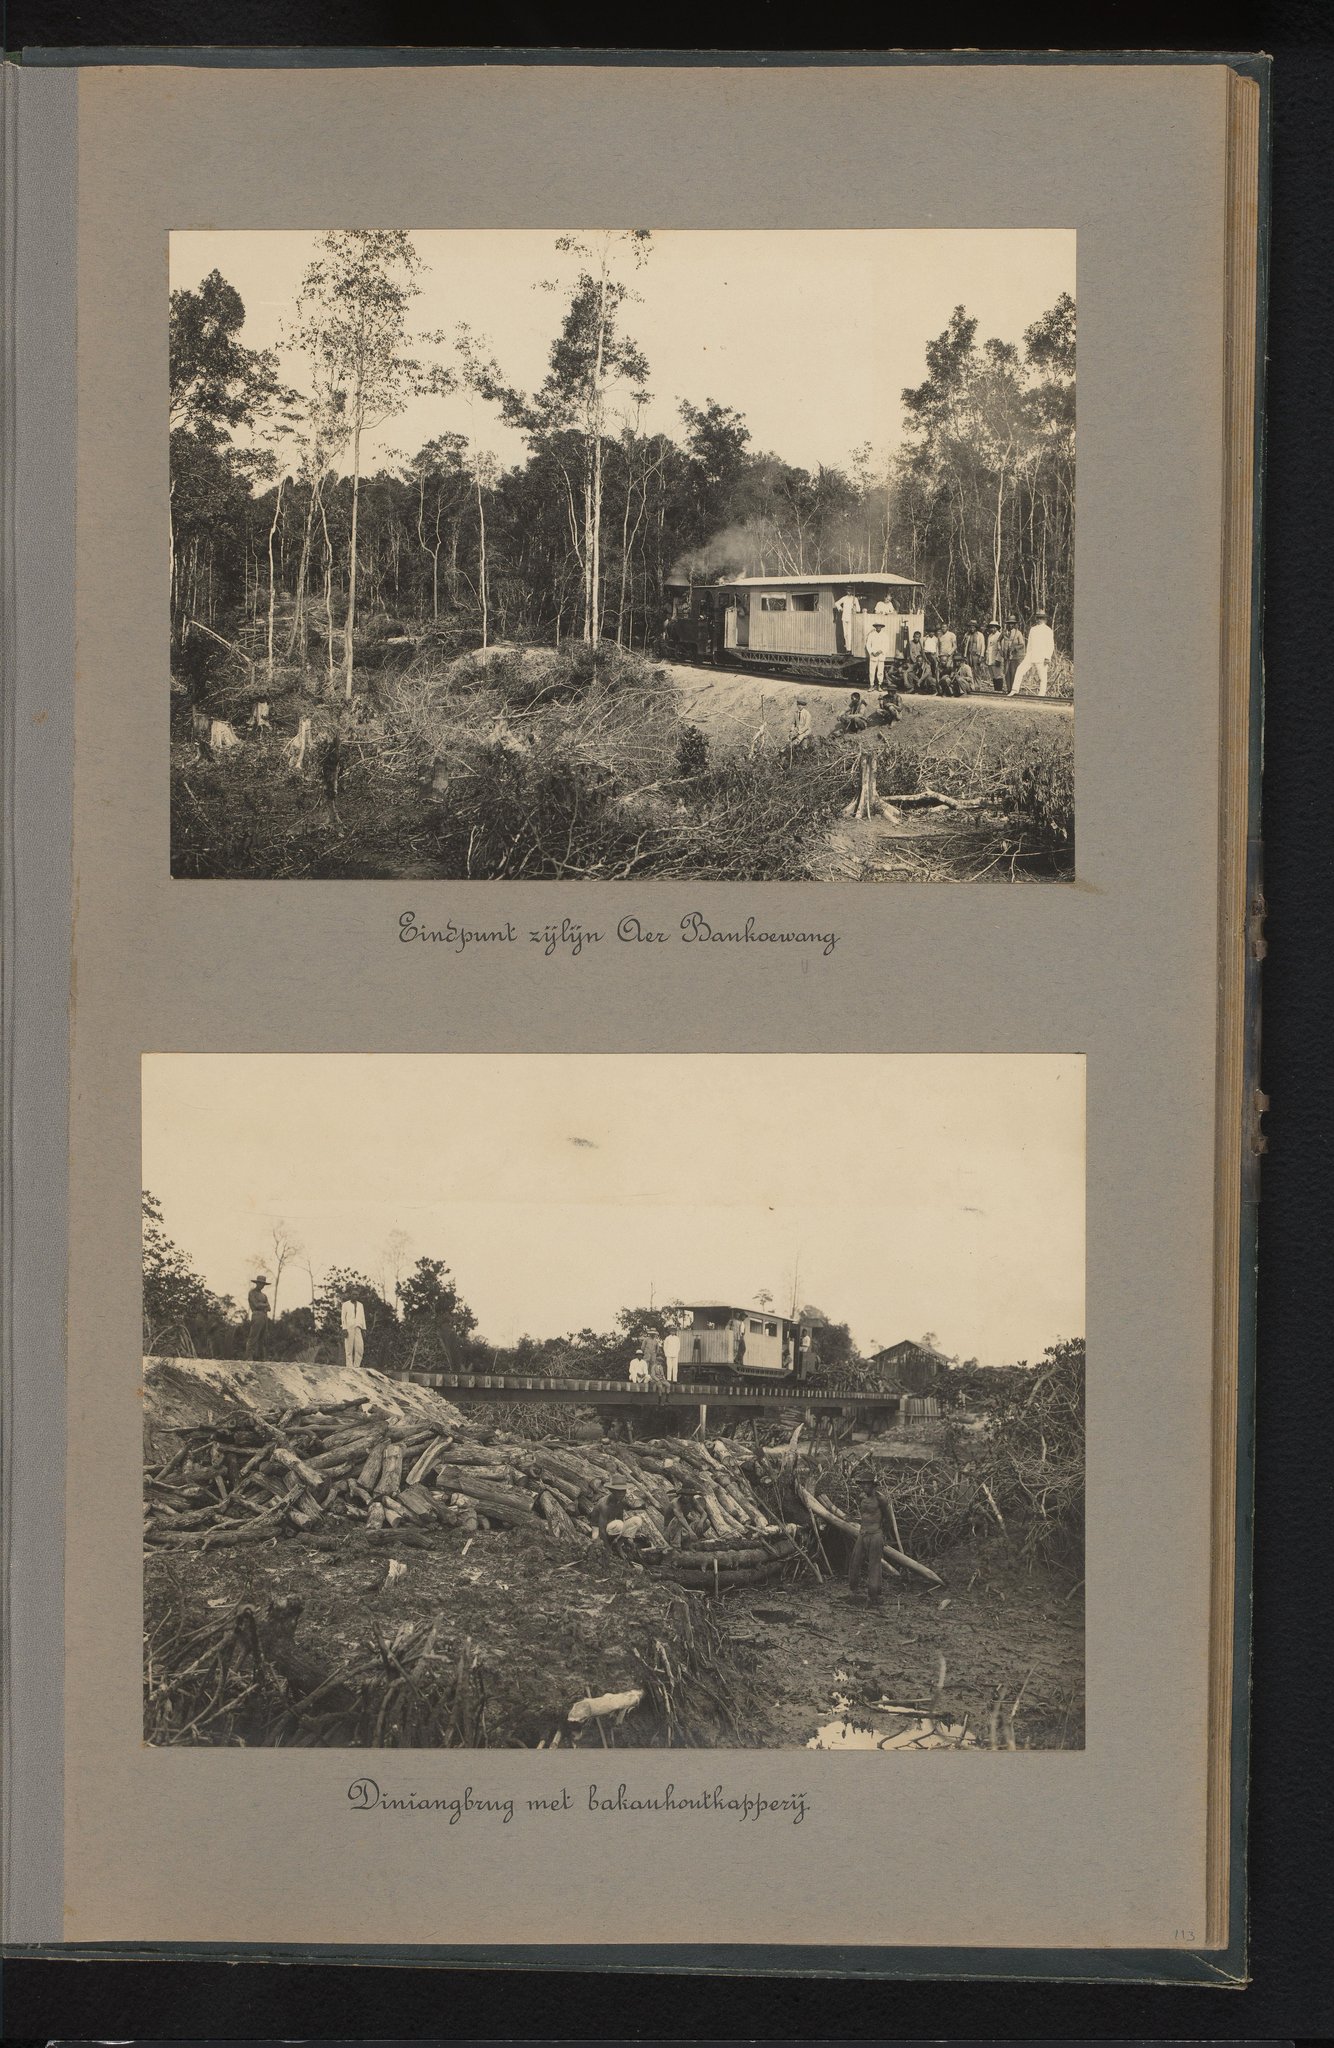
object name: album leaf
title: Stoomtram van de Banka-tinwinning te Soengeiliat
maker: Anonymous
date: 1914-1919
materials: cardboard, photographic support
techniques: gelatin silver print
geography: bangka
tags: robert julius boers, colonial system, mining, railway, tramway; rack railway (+ propulsion of vehicle, ship, etc. by steam), clearing ~ forest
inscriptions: inscription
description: Albumblad met 2 foto's van het eindpunt van de stoomtram en van een houtkapperij bij een brug van de Banka-tinwinning te Soengeiliat. Onderdeel van het fotoalbum aangeboden aan Robert Julius Boers bij zijn vertrek naar Nederland in 1919 door het personeel van de Banka-tinwinning.